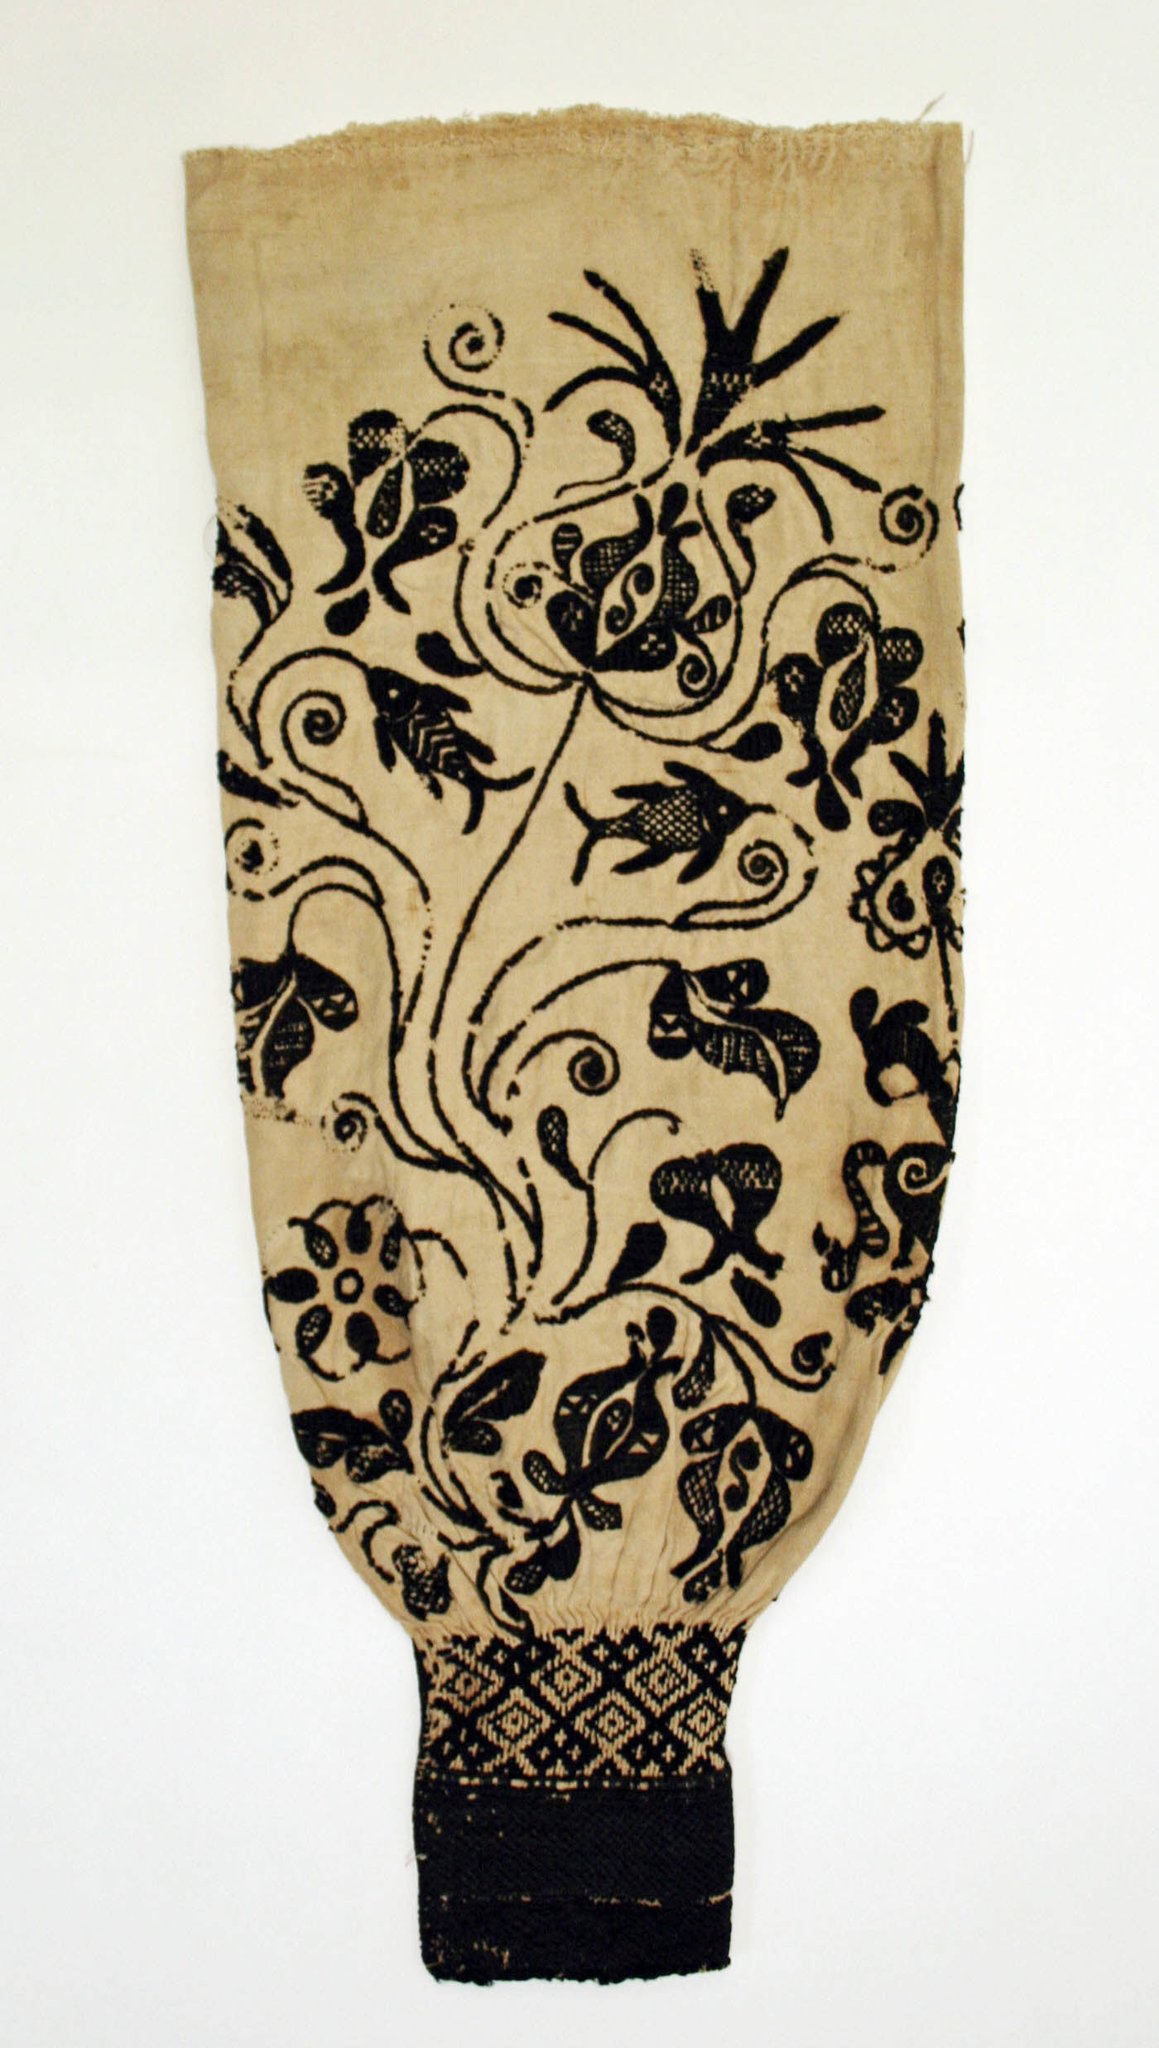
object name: sleeve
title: Sleeves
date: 1601-1800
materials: linen, wool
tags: fish